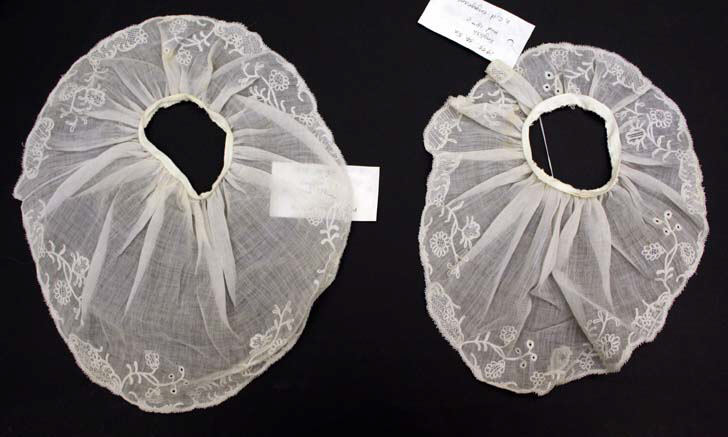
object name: engageantes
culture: british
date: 1734-1766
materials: cotton